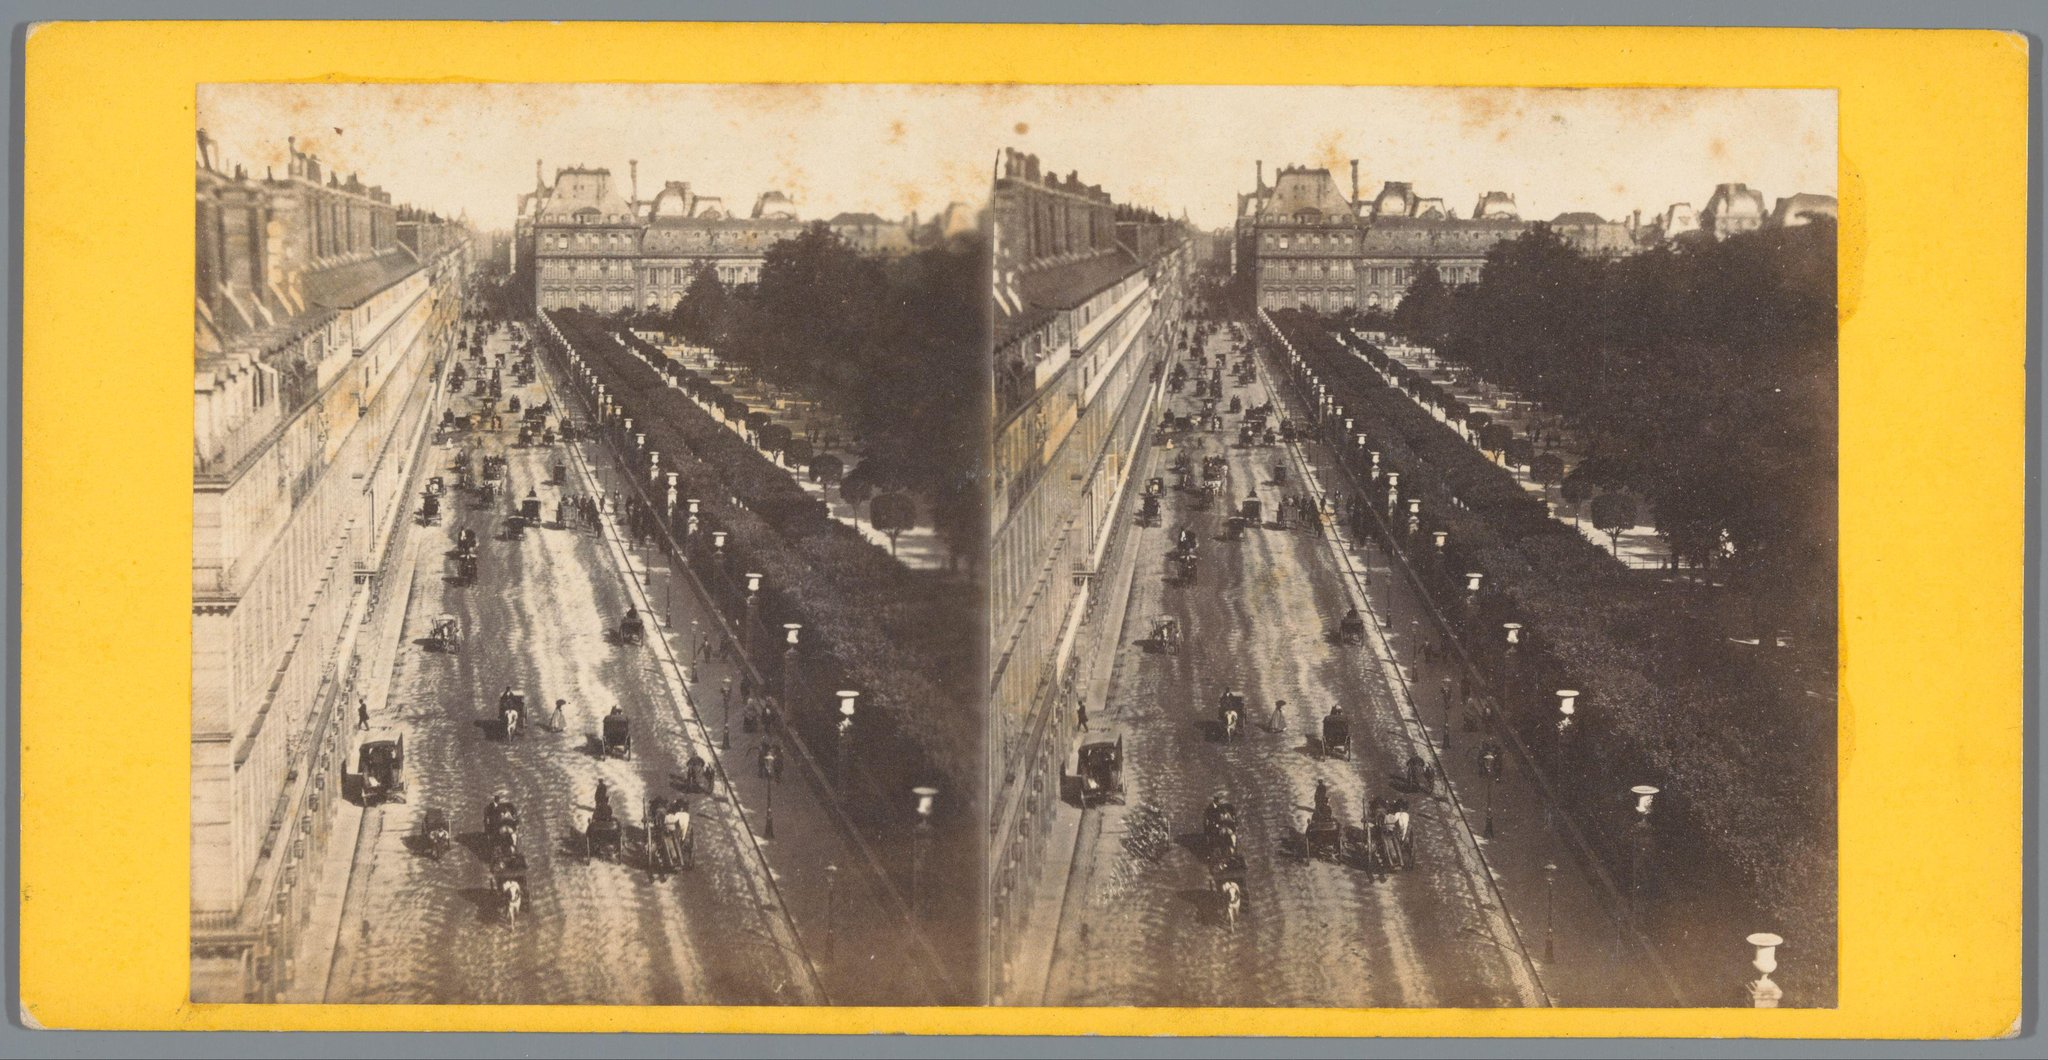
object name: stereograph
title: Gezicht op de Rue de Rivoli in Parijs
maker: Anonymous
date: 1850-1880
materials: cardboard, photographic support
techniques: albumen print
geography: paris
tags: animal traction, animal-drawn vehicle (carriage etc.), street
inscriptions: inscription: ‘Rue de Rivoli’